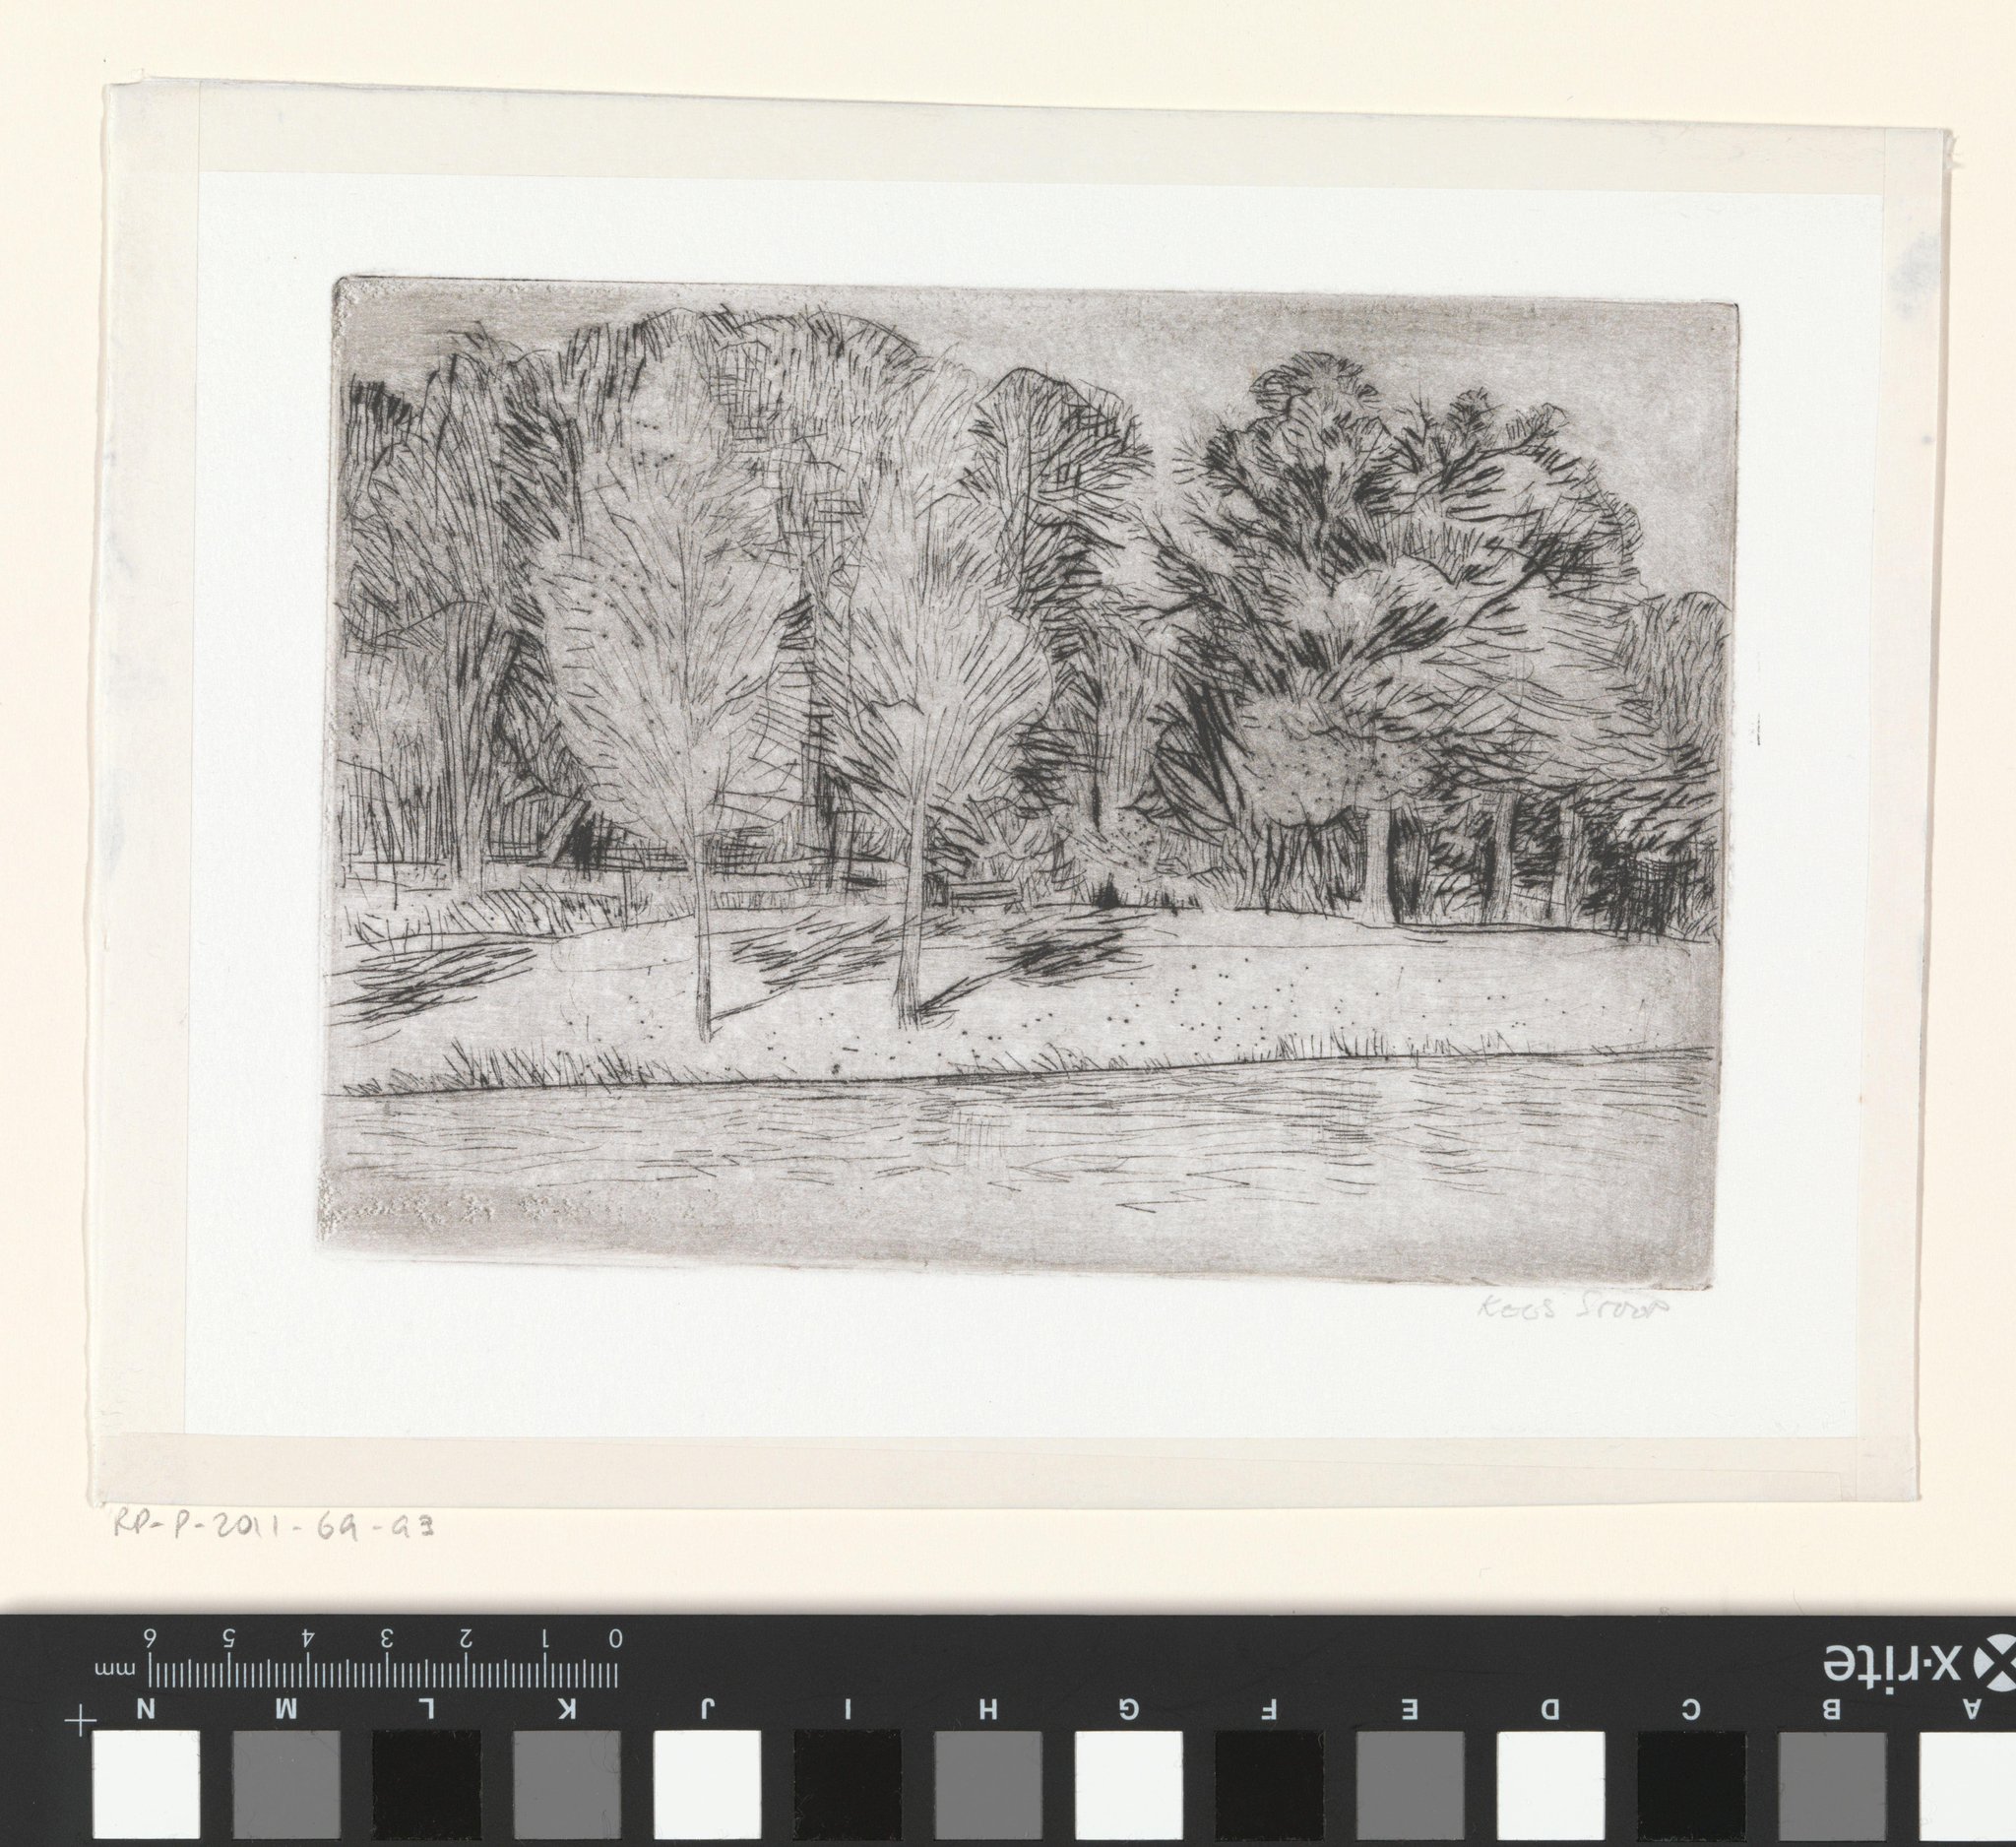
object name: print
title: Park aan het water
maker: kees stoop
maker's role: draughtsman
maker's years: 1929-2019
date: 1944-1990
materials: paper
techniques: drypoint, intaglio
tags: park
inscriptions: signature and date: ‘KEES STOOP’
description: Park aan het water, in het midden van de voorstelling een bank.